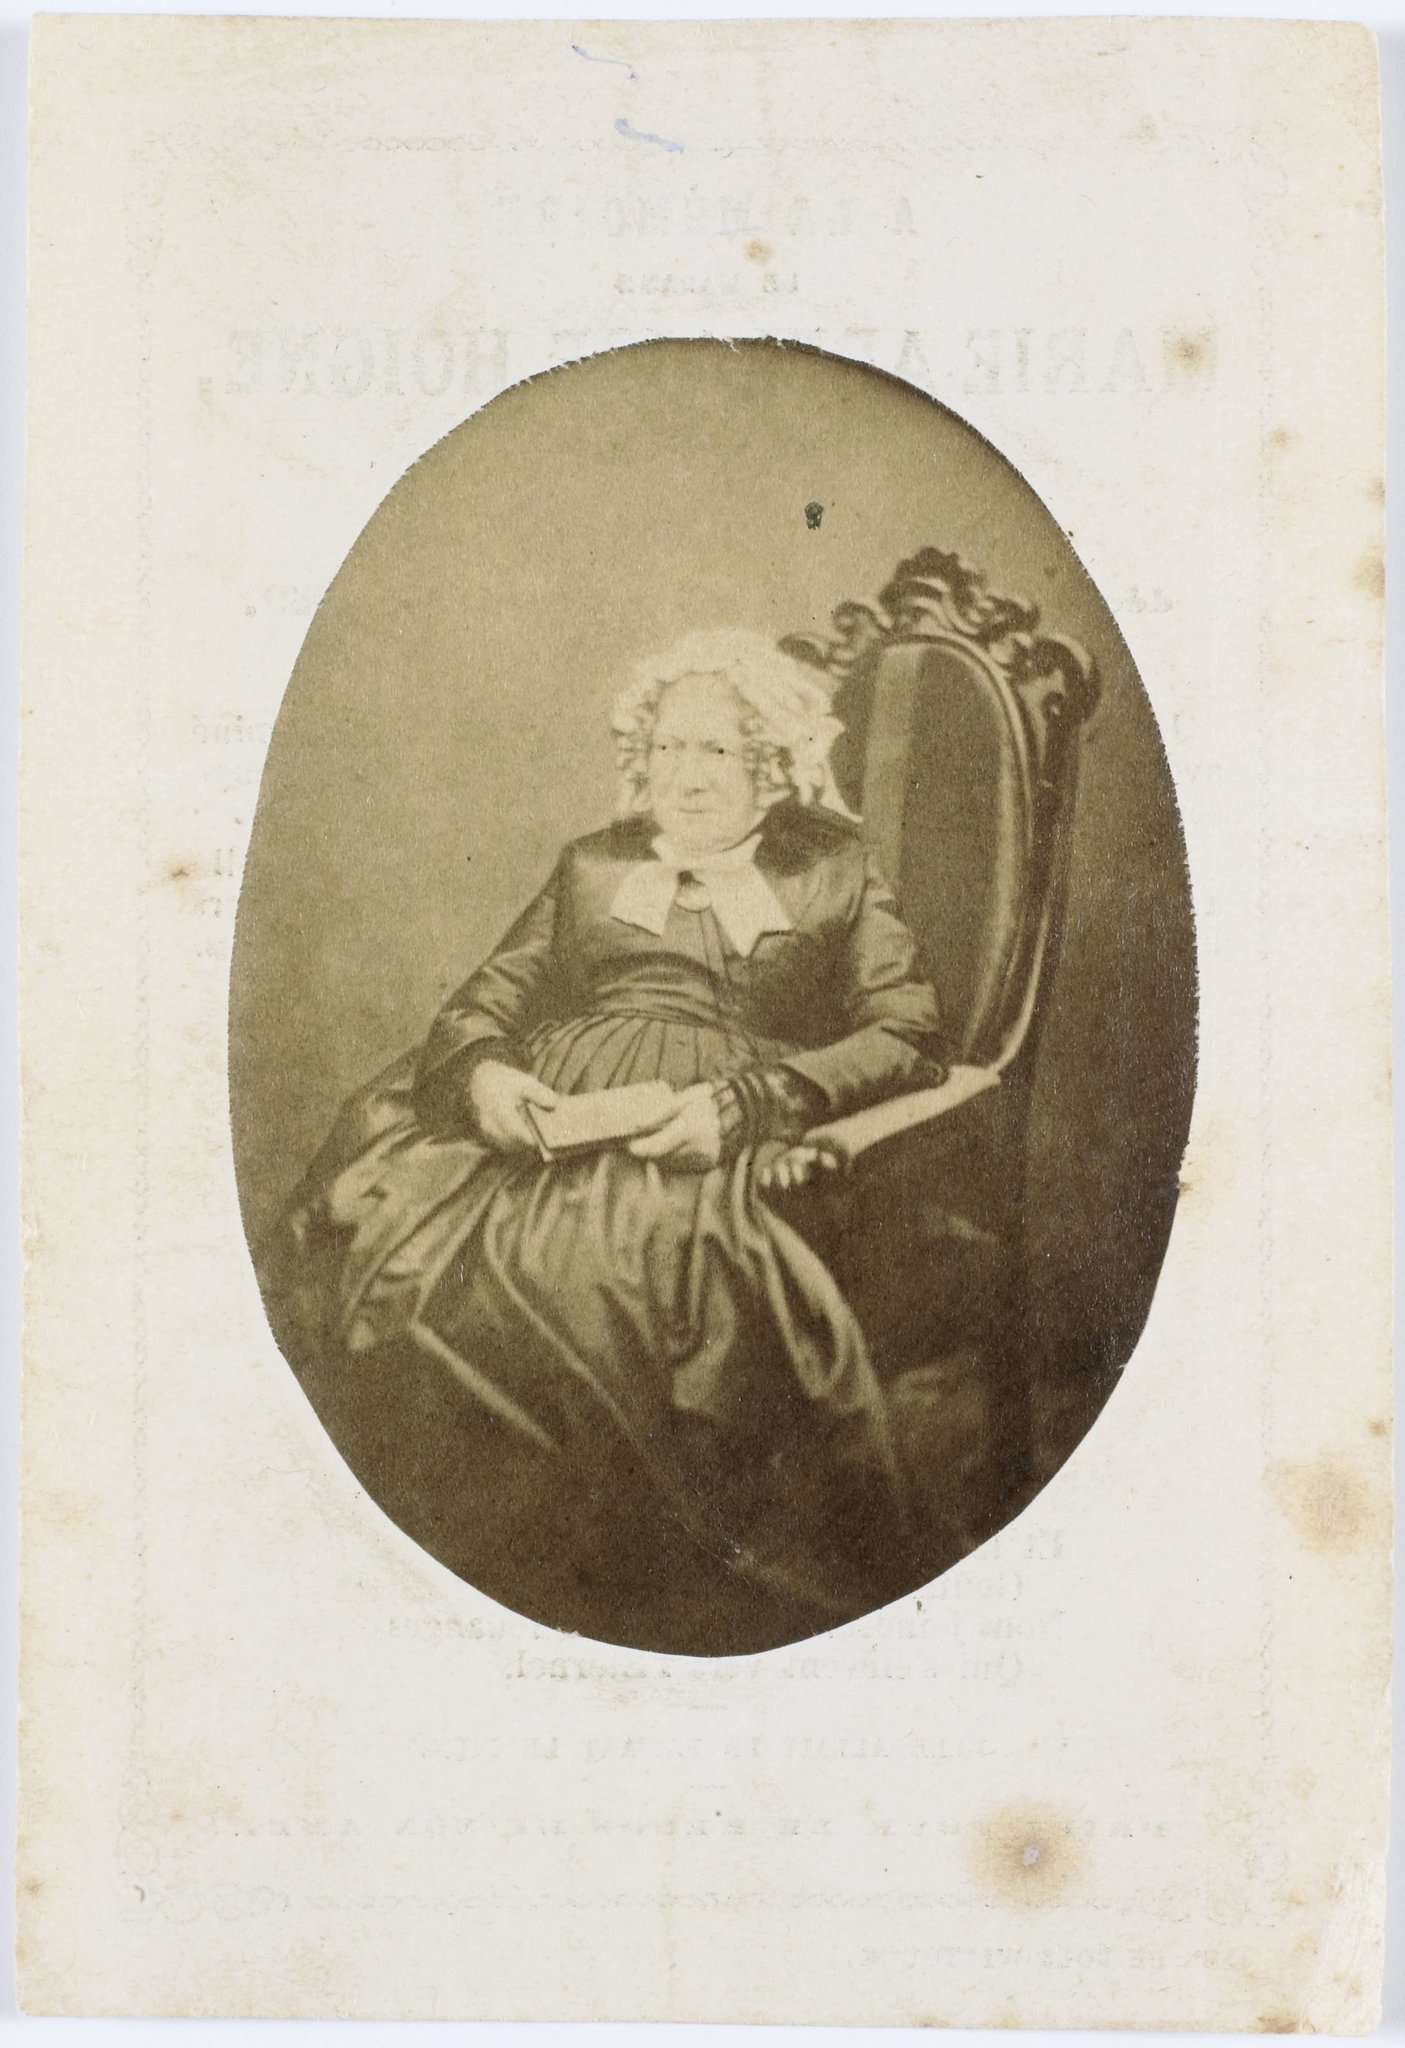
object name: photograph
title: Portret van Marie-Adelaide Hoigne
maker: Anonymous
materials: paper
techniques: albumen print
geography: brussels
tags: adult woman, historical persons, rotterdam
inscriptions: inscription: ‘A LA MÉMOIRE/ DE MADAME (...)’